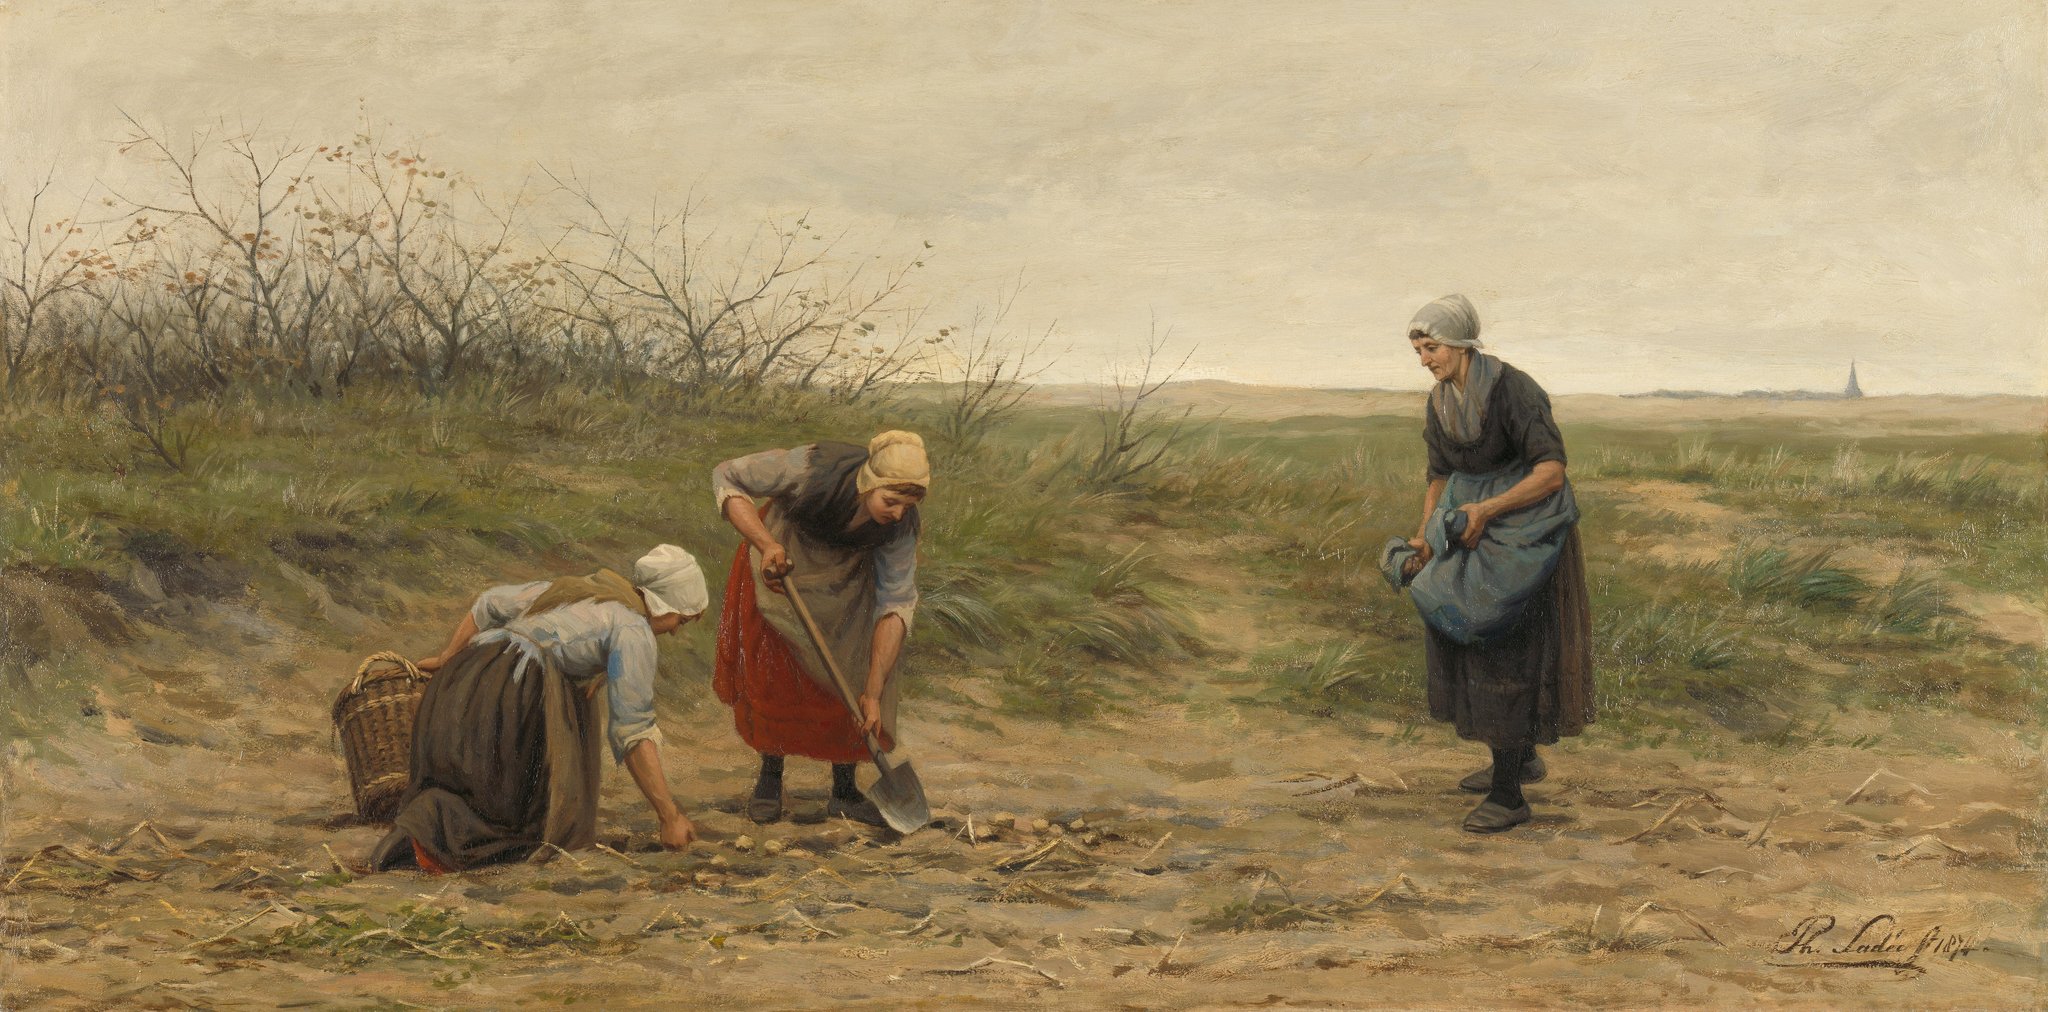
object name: painting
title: Scheveningse vrouwen bij het nalezen van een gerooid aardappelveld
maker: philip sadée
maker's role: draughtsman, painter, print maker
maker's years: 1837-1904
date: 1874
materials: canvas, oil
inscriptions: signature and date: ‘Ph. Sadée ft 1874’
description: Scheveningse vrouwen bij het nalezen van een gerooid aardappelveld. Een vrouw knielt bij een mand, een ander schept en de laatste verzamelt de aardappels in haar schort.